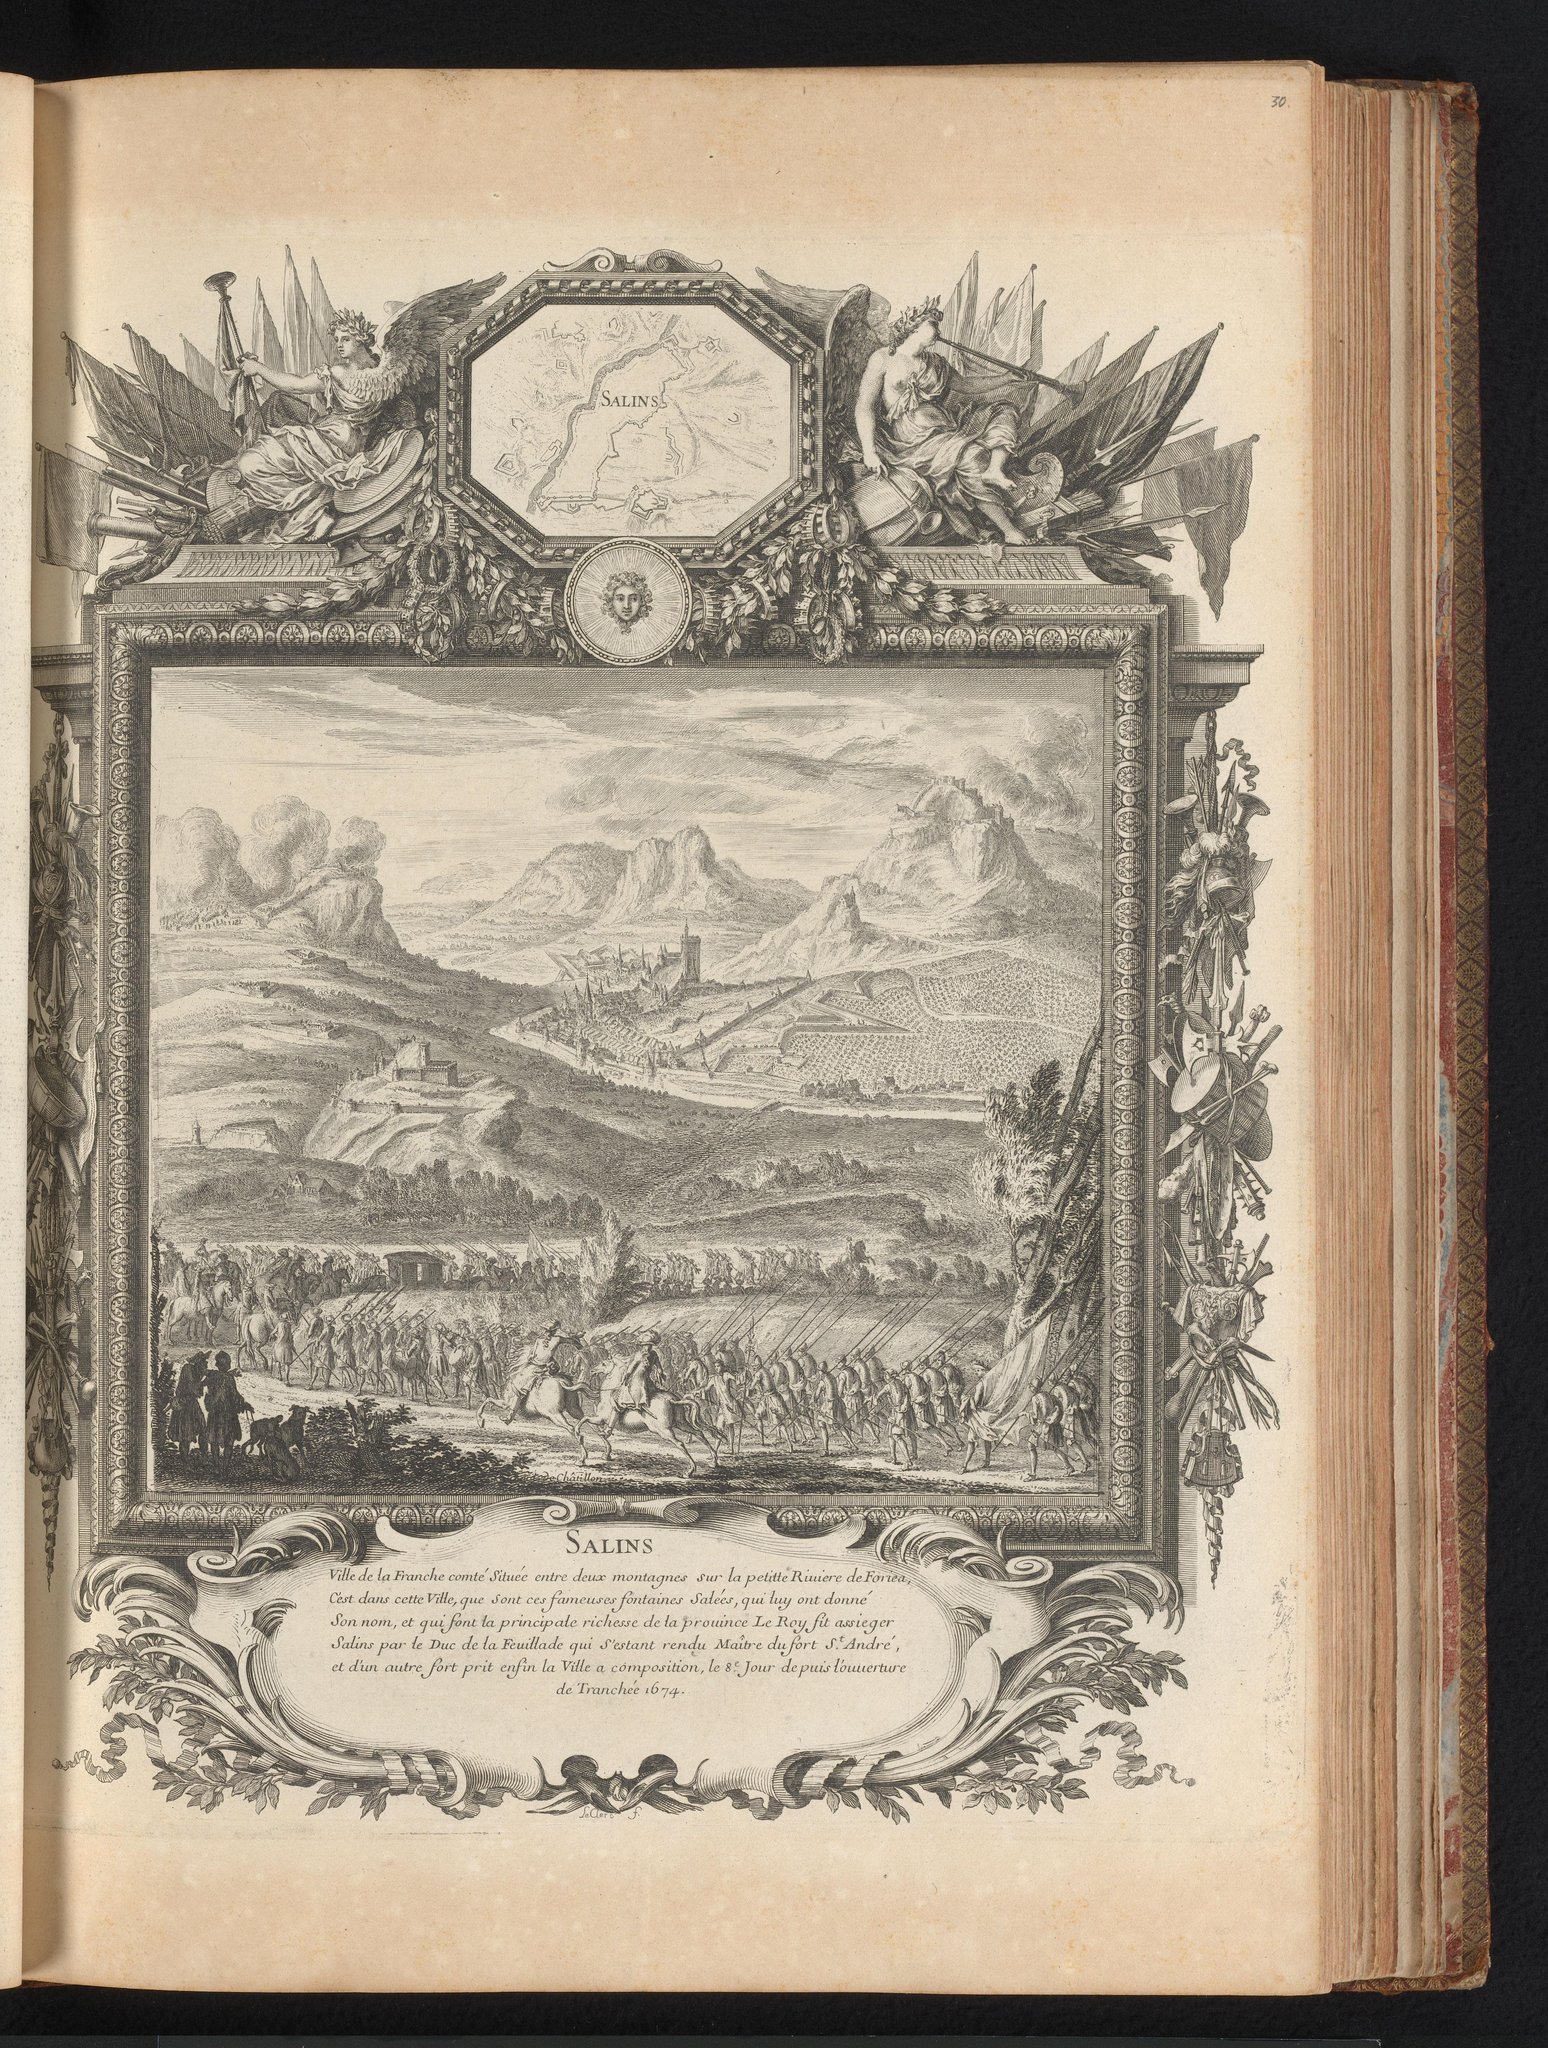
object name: album leaf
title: Grote overwinningen van koning Lodewijk XIV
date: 1686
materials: paper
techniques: engraving, etching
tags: battle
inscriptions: watermark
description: Maakt deel uit van een serie bestaande uit 28 prenten met oorlogstaferelen in ornamentele cartouches. De prenten zijn gedrukt van twee afzonderlijke platen bestaande uit de voorstelling en de cartouche.